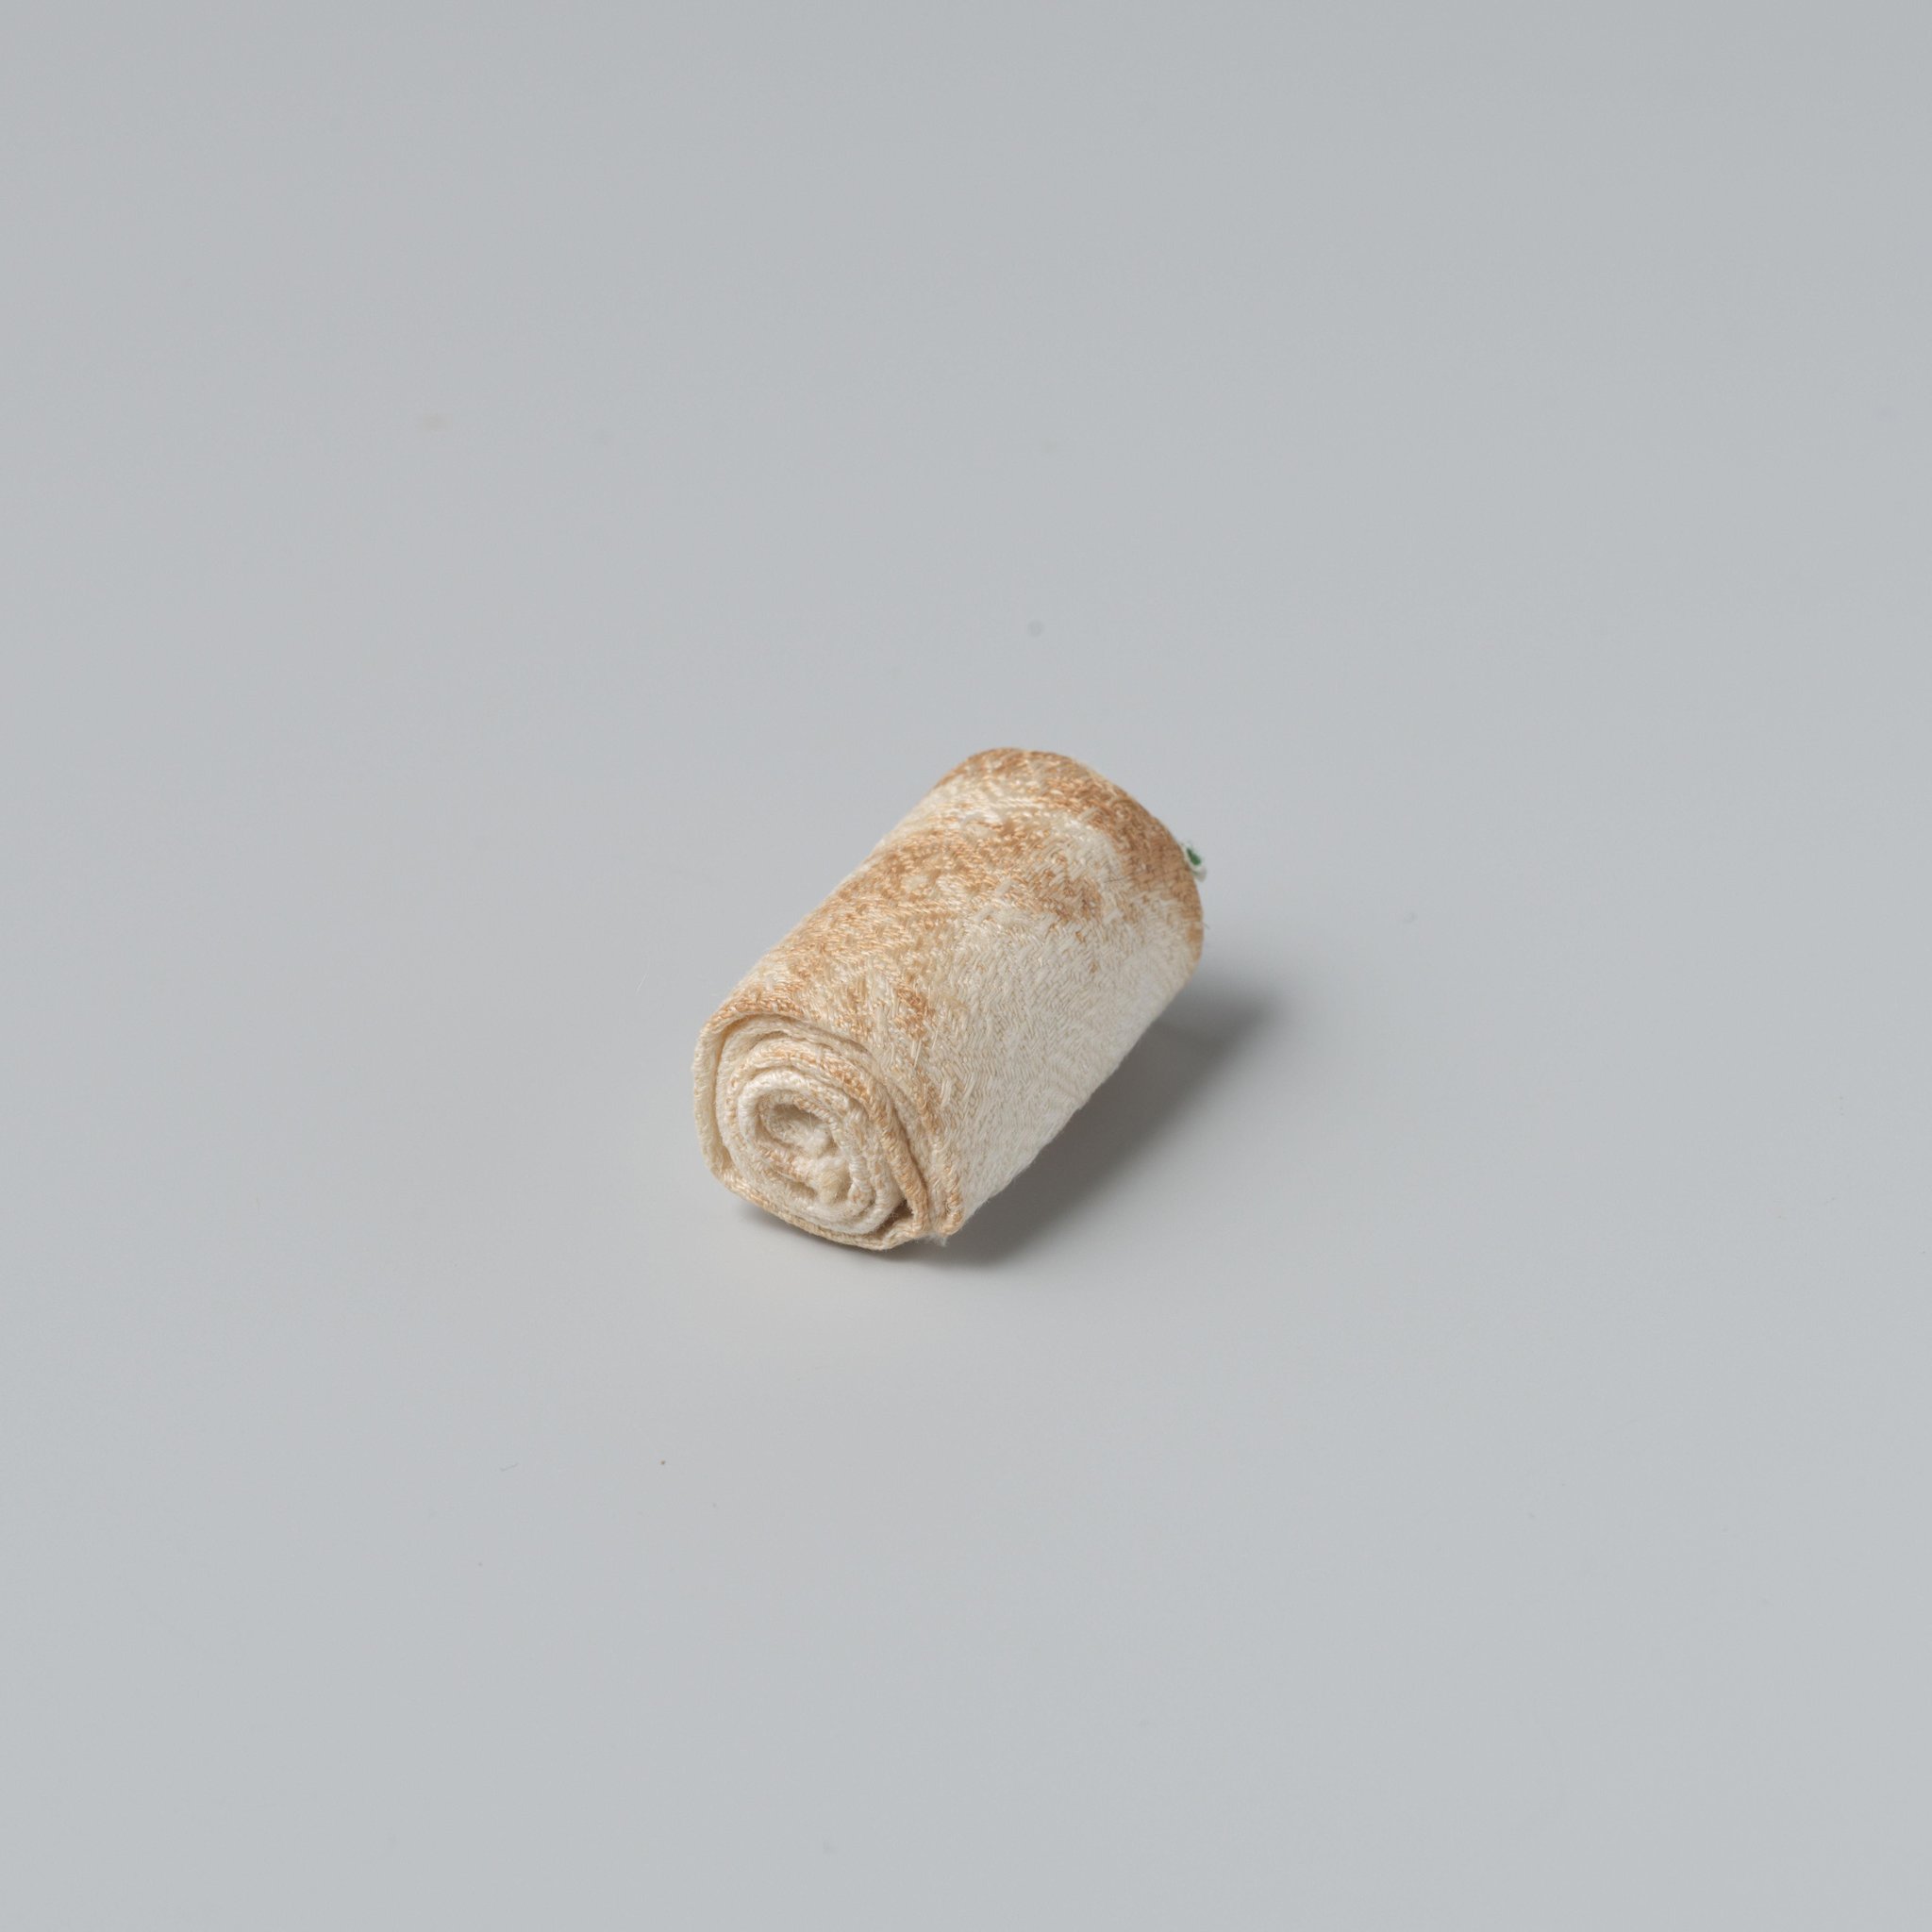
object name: miniature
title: Rol linnen, damastweefsel met pellenpatroon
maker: Anonymous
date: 1600-1699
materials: linen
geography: netherlands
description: Rol linnen, damastweefsel met pellenpatroon.